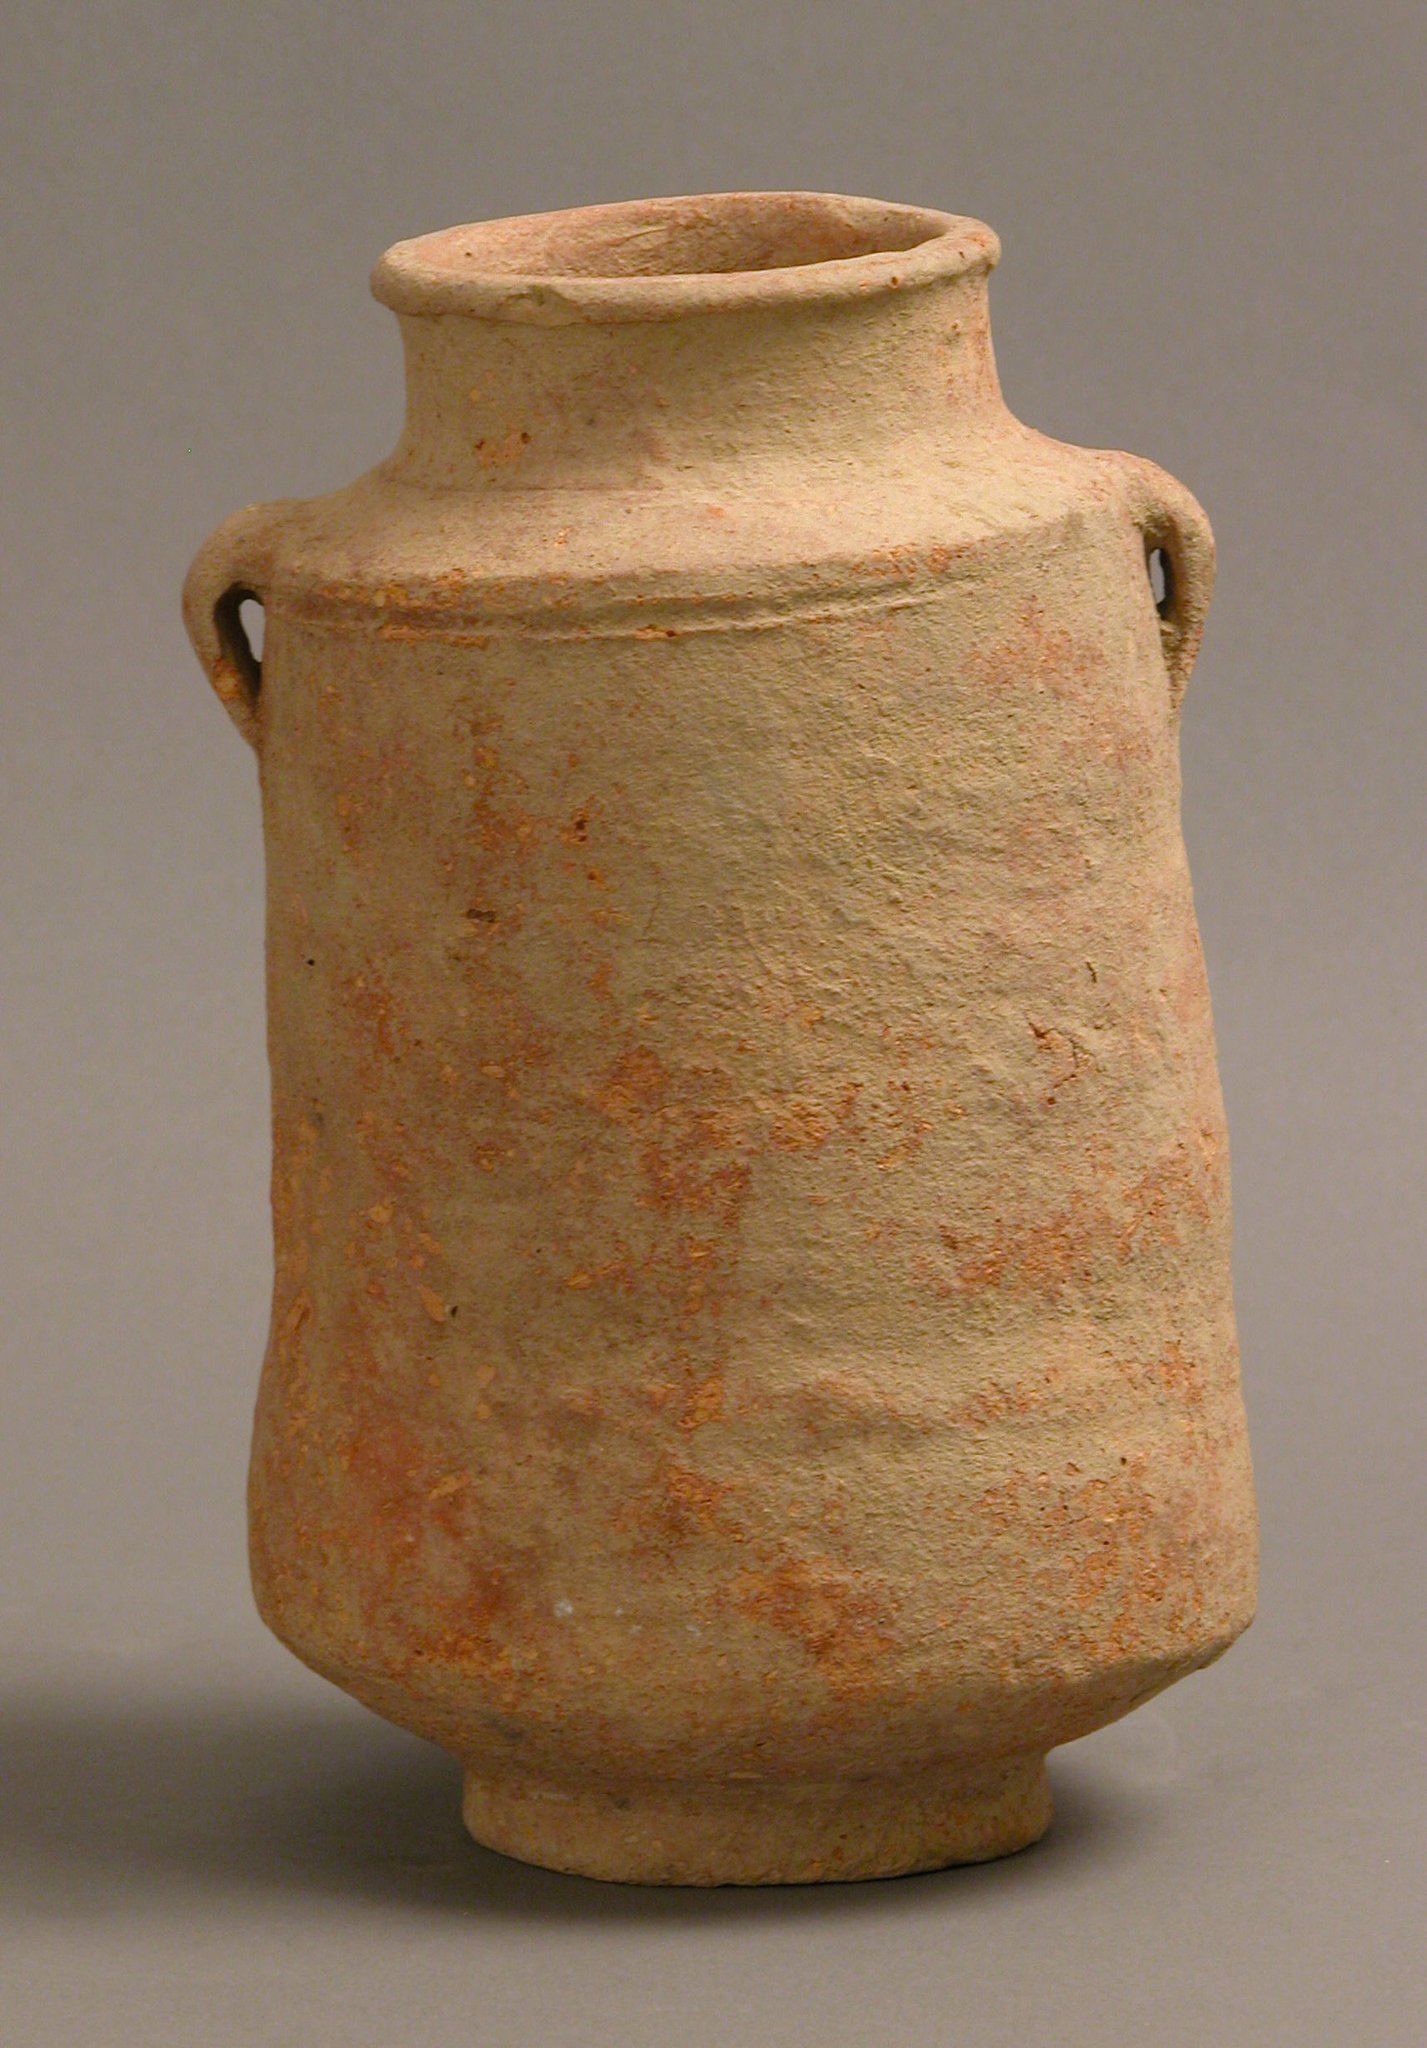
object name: jar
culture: coptic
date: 301-700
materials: earthenware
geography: egypt